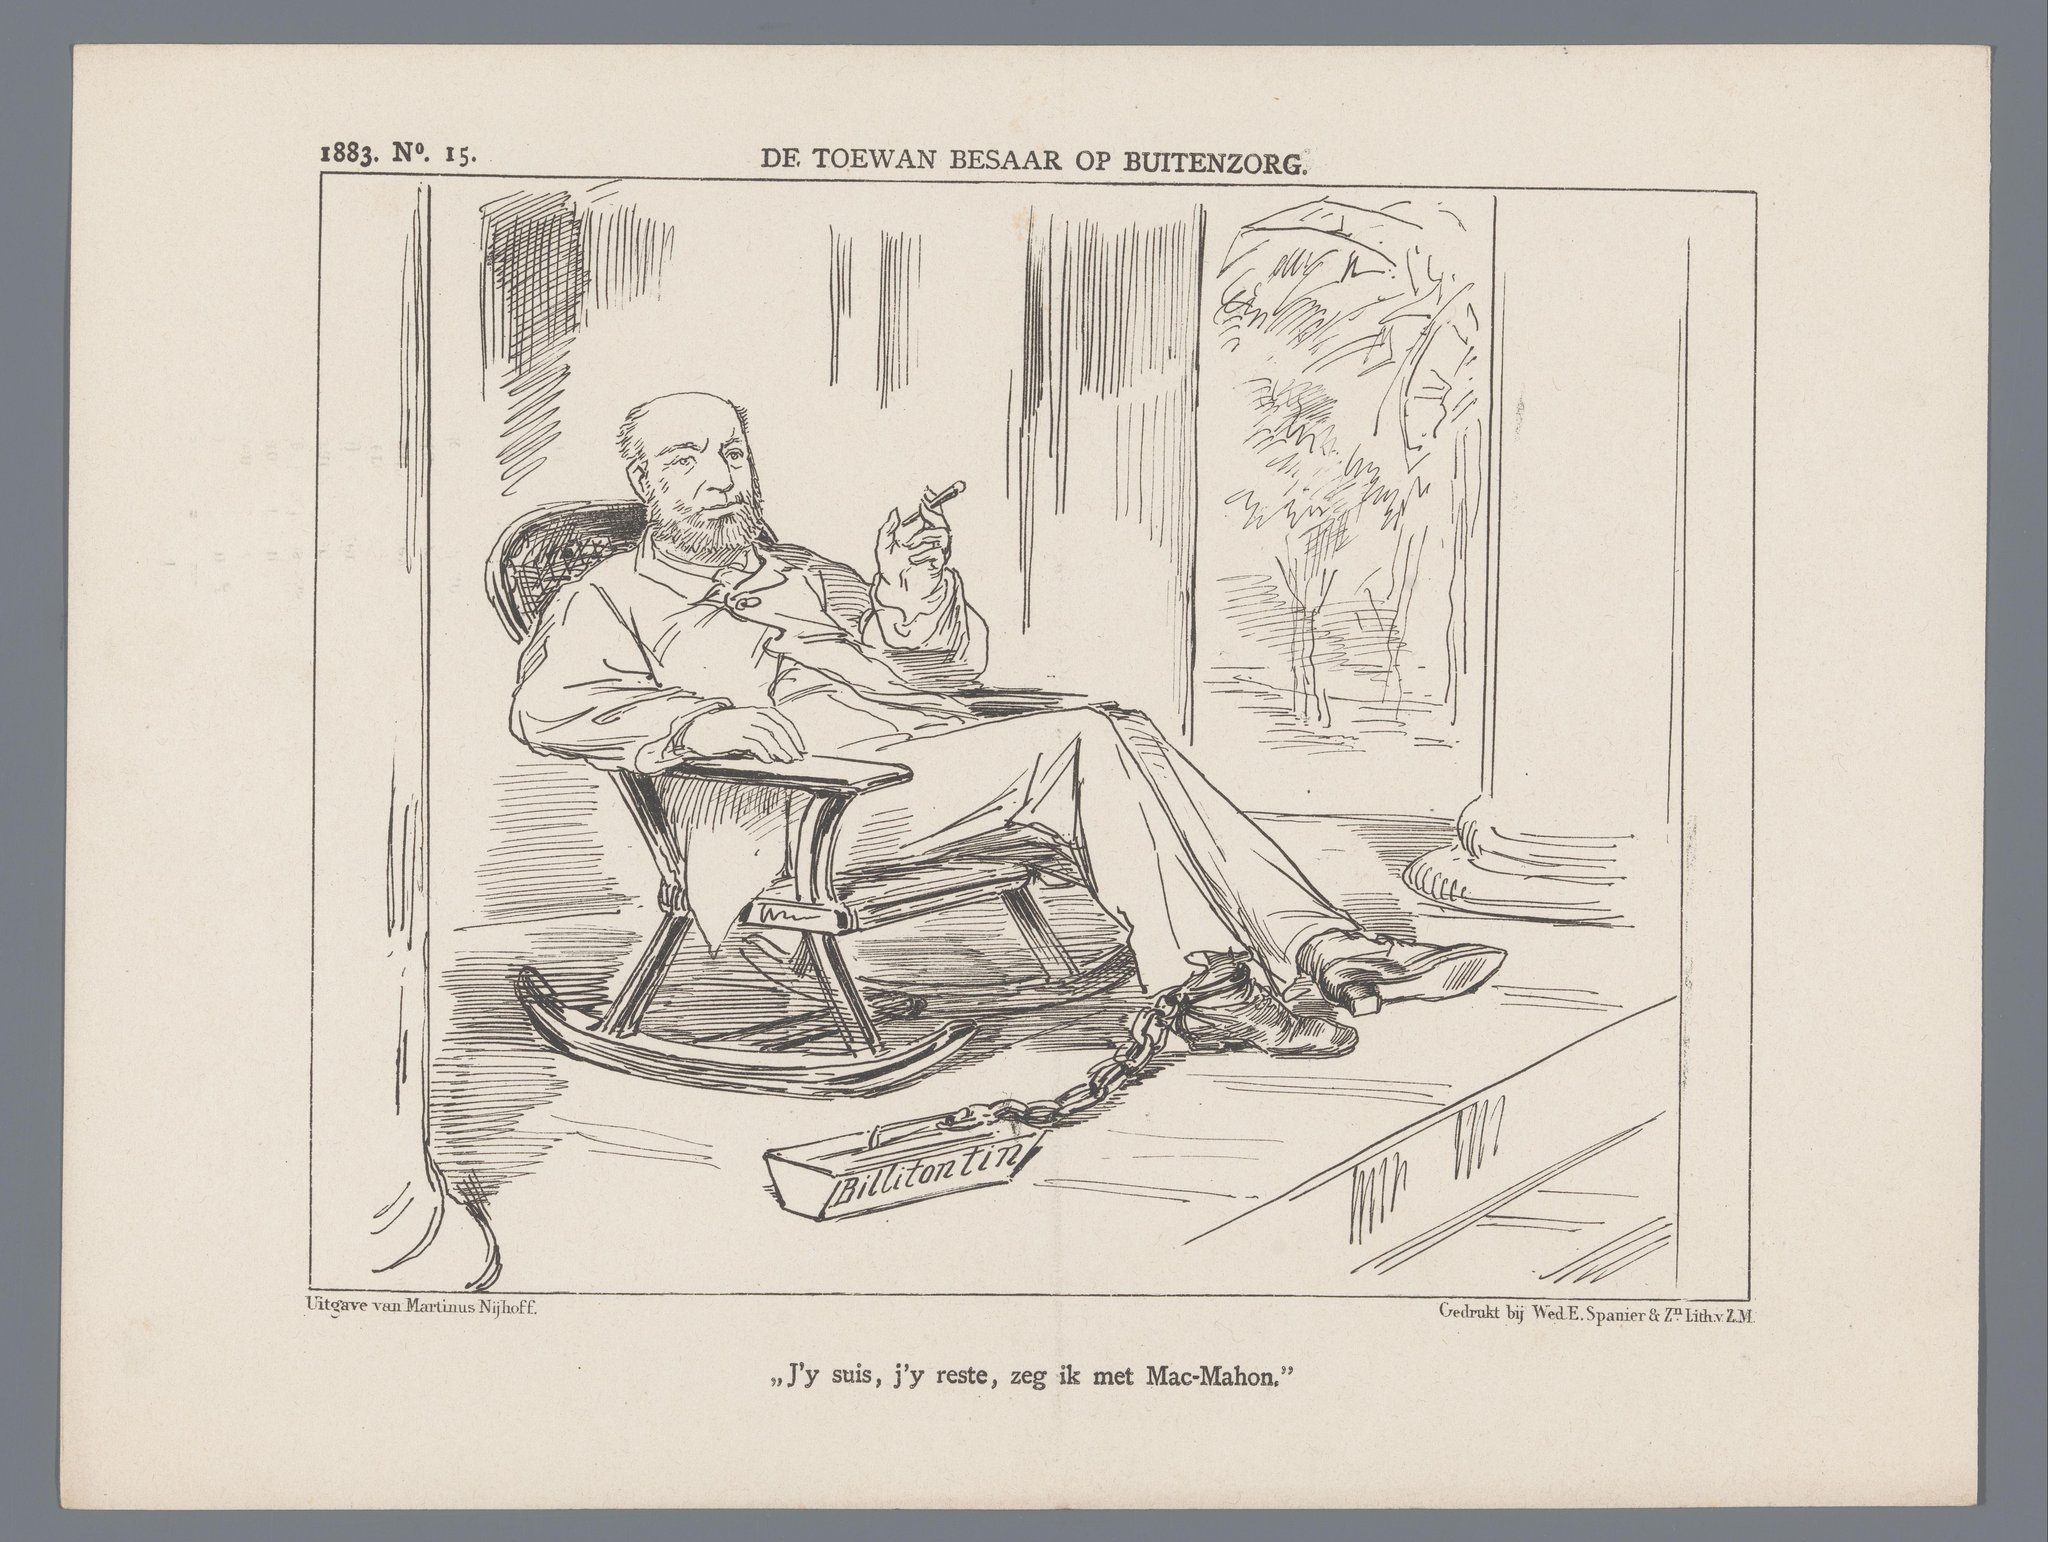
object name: print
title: De toewan besaar op Buitenzorg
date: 1883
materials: paper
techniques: lithograph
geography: the hague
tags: minister van koloniën, willem maurits de brauw, buitenzorg, billiton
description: Spotprent op de afgetreden Minister van Koloniën Willem Maurits de Brauw. Aan zijn voet het Billiton-schandaal van zijn voorganger. Plaat verschenen bij het weekblad De Nederlandsche Spectator, nr. 15, 1883.